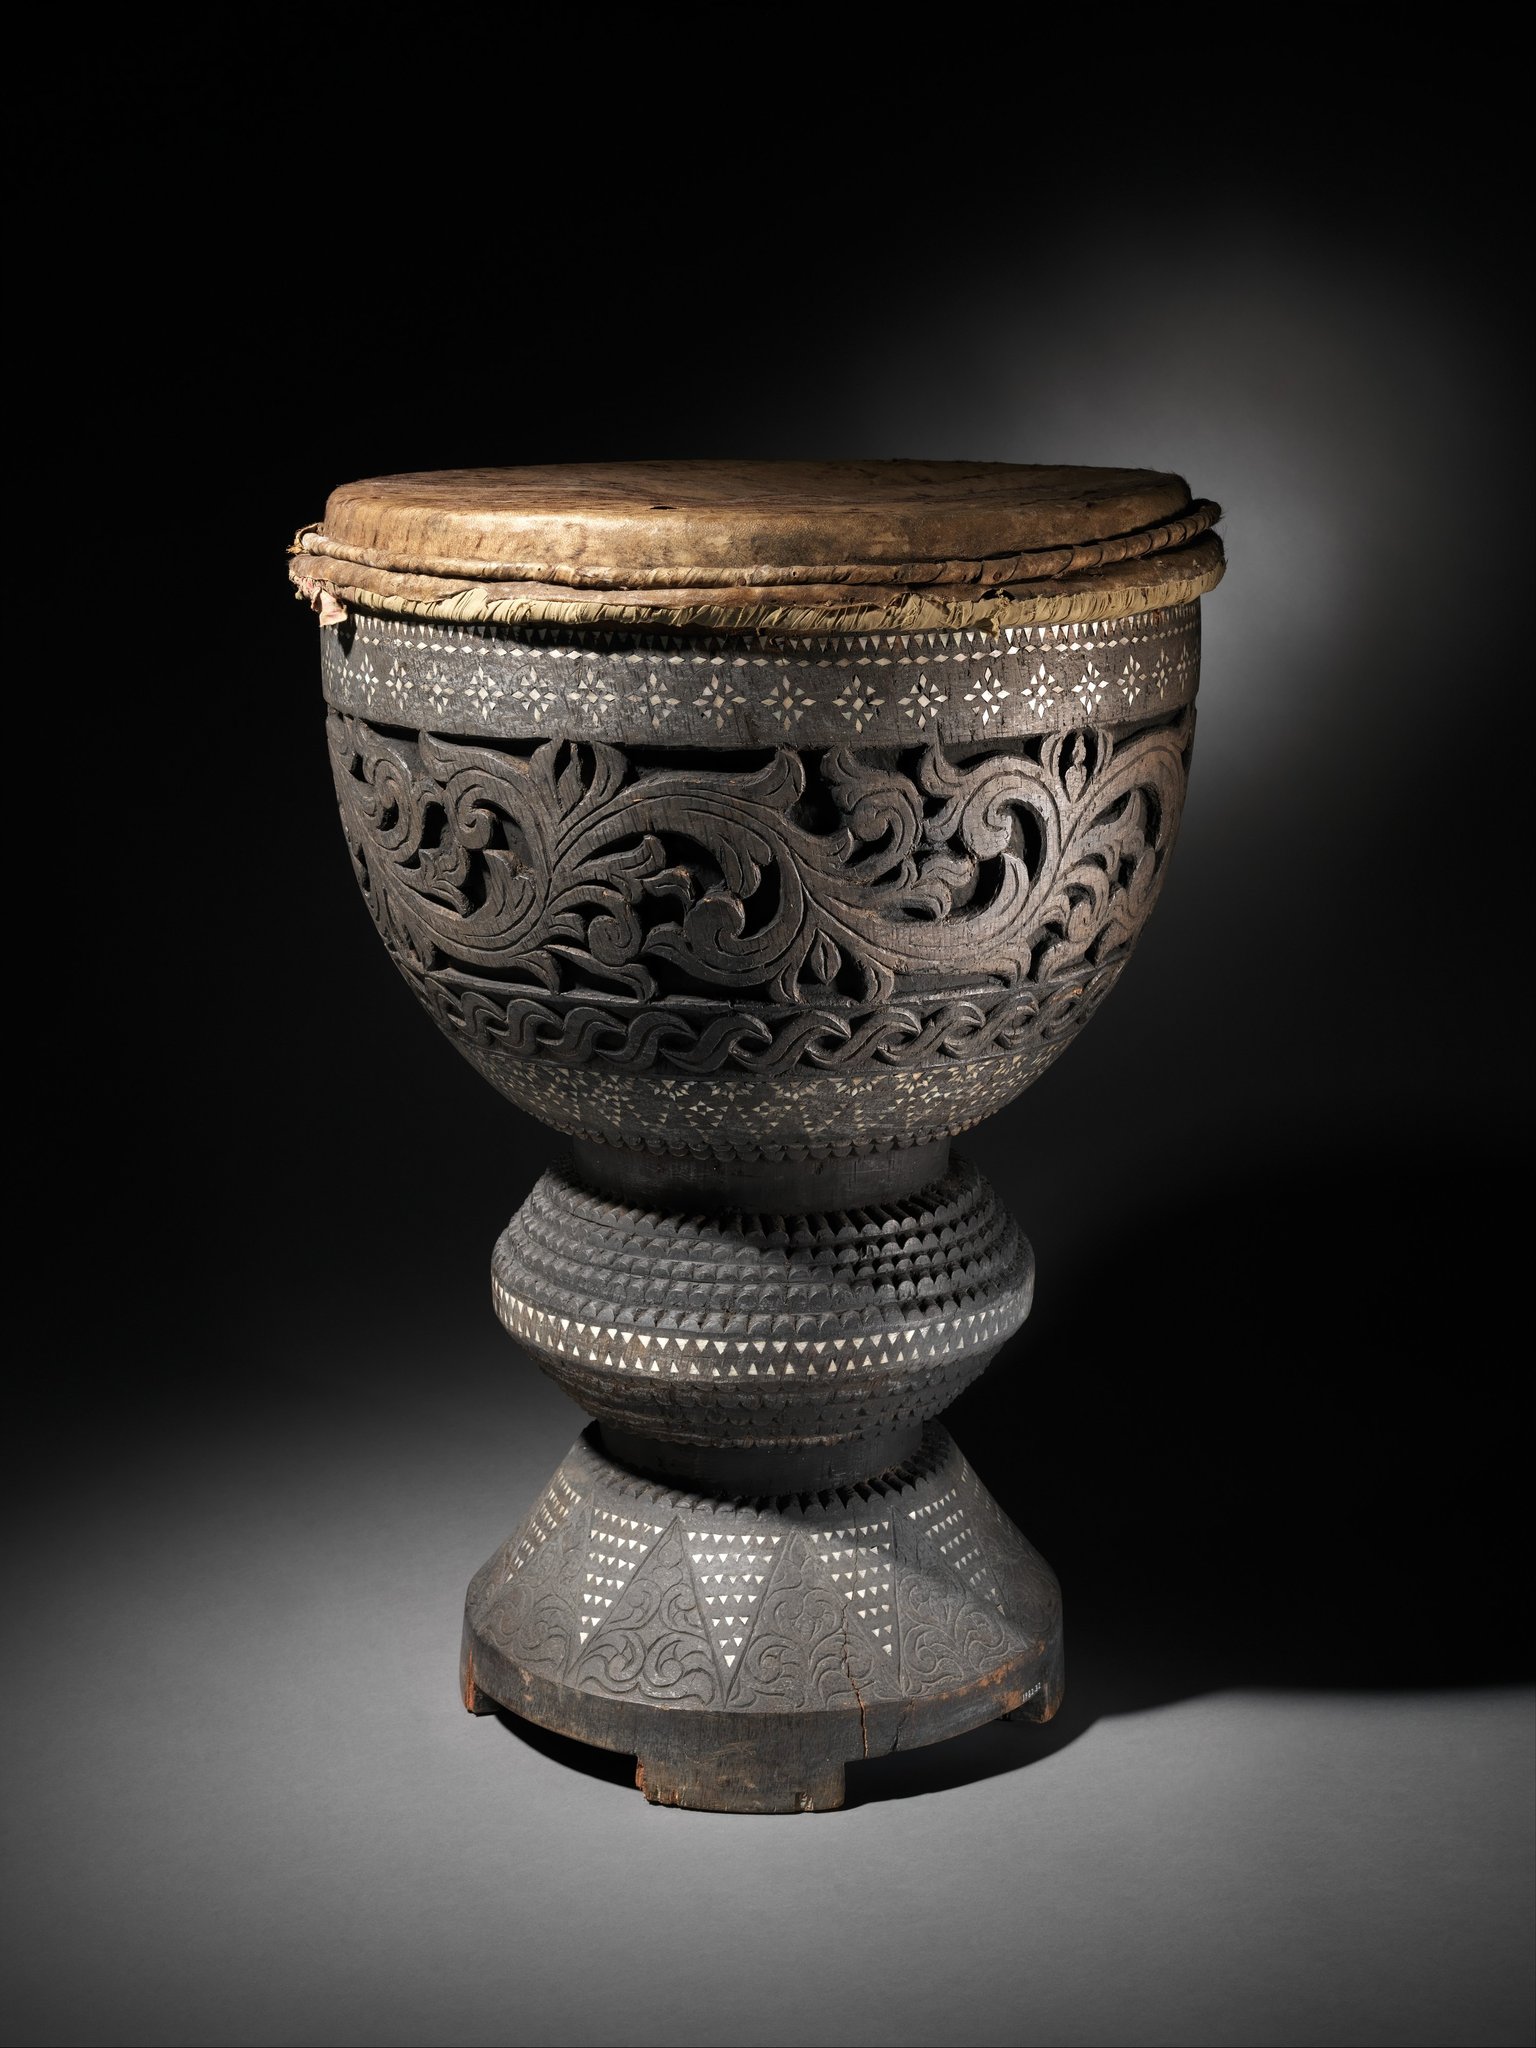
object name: dadabuan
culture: philippine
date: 1801-1900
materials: mother of pearl, skin, wood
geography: philippines